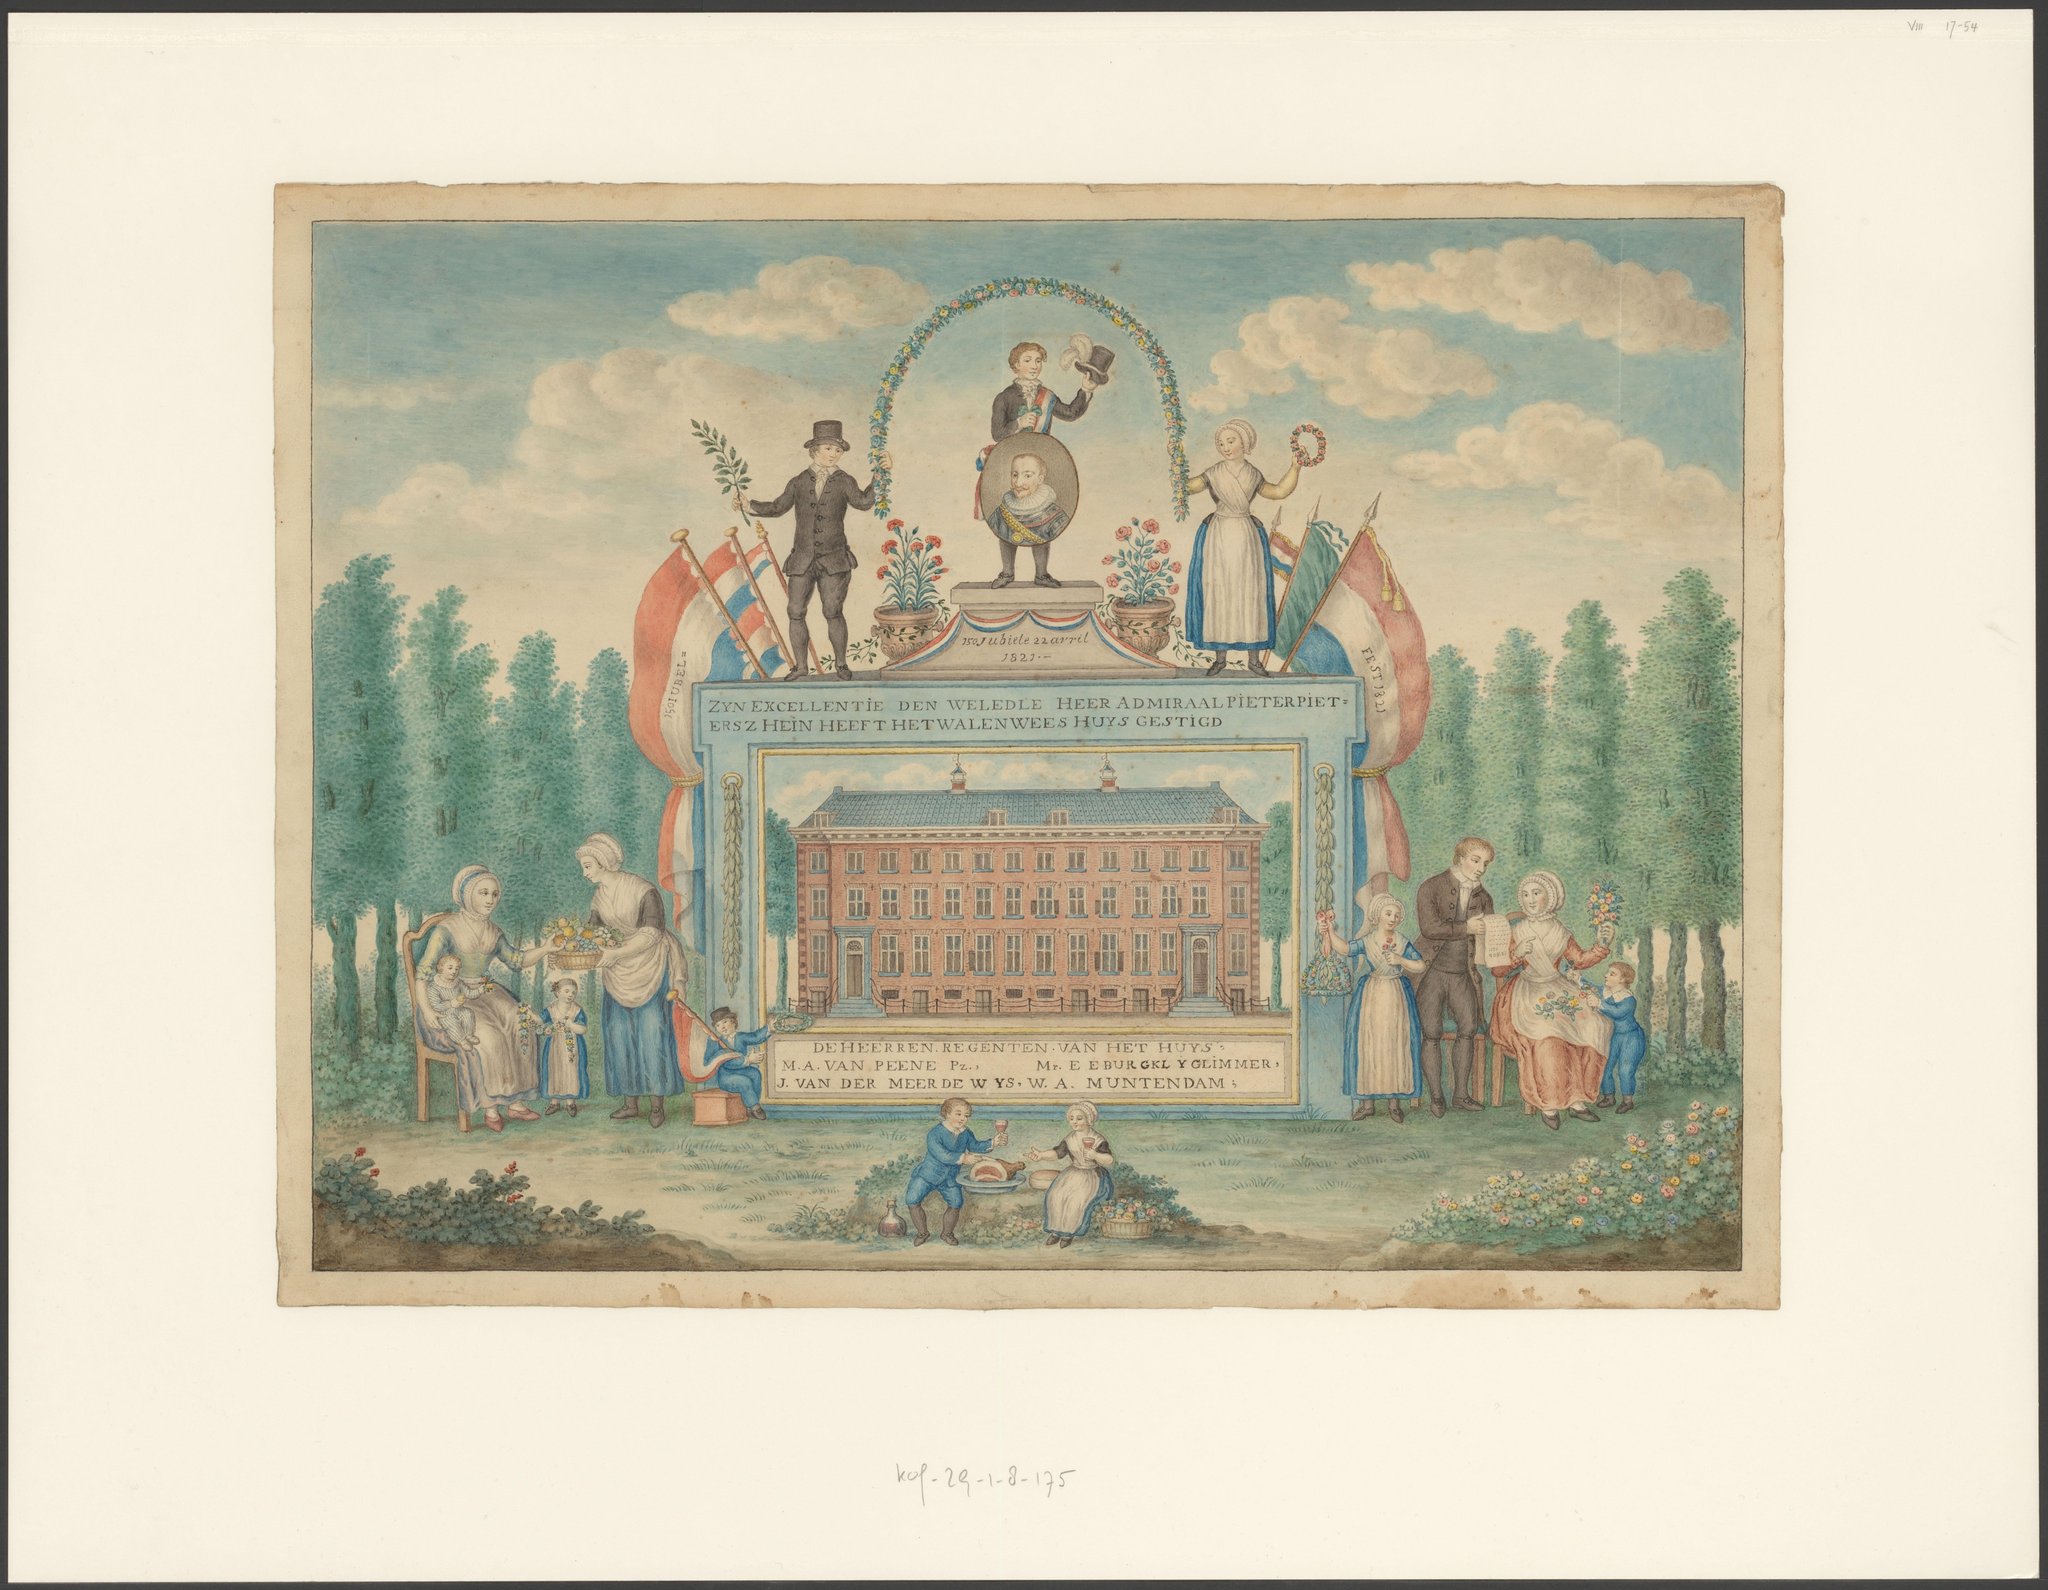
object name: drawing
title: Zyn Excellentie den weledle. Heer Admiraal Pieter Pietersz Hein heeft het Walen Wees Huys gestigd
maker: Anonymous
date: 1821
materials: paper, watercolor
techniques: brush, pen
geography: netherlands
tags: delfshaven, orphanage, orphans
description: Feestelijke viering van het honderdvijftigjarig bestaan van het Walenweeshuis te Amsterdam op 22 april 1821. Vooraanzicht van het weeshuis tussen bomen met links en rechts de opvang van weeskinderen. Bovenop vlaggen en een ereboog om het portret van de stichter van het oorspronkelijke gebouw (1631-1671) admiraal Piet Hein. Onderaan de namen van de huidige regenten. Onderwerpsrubrieken binnen de Atlas Zeden en Gewoonten: Armwezen en Liefdadigheid.